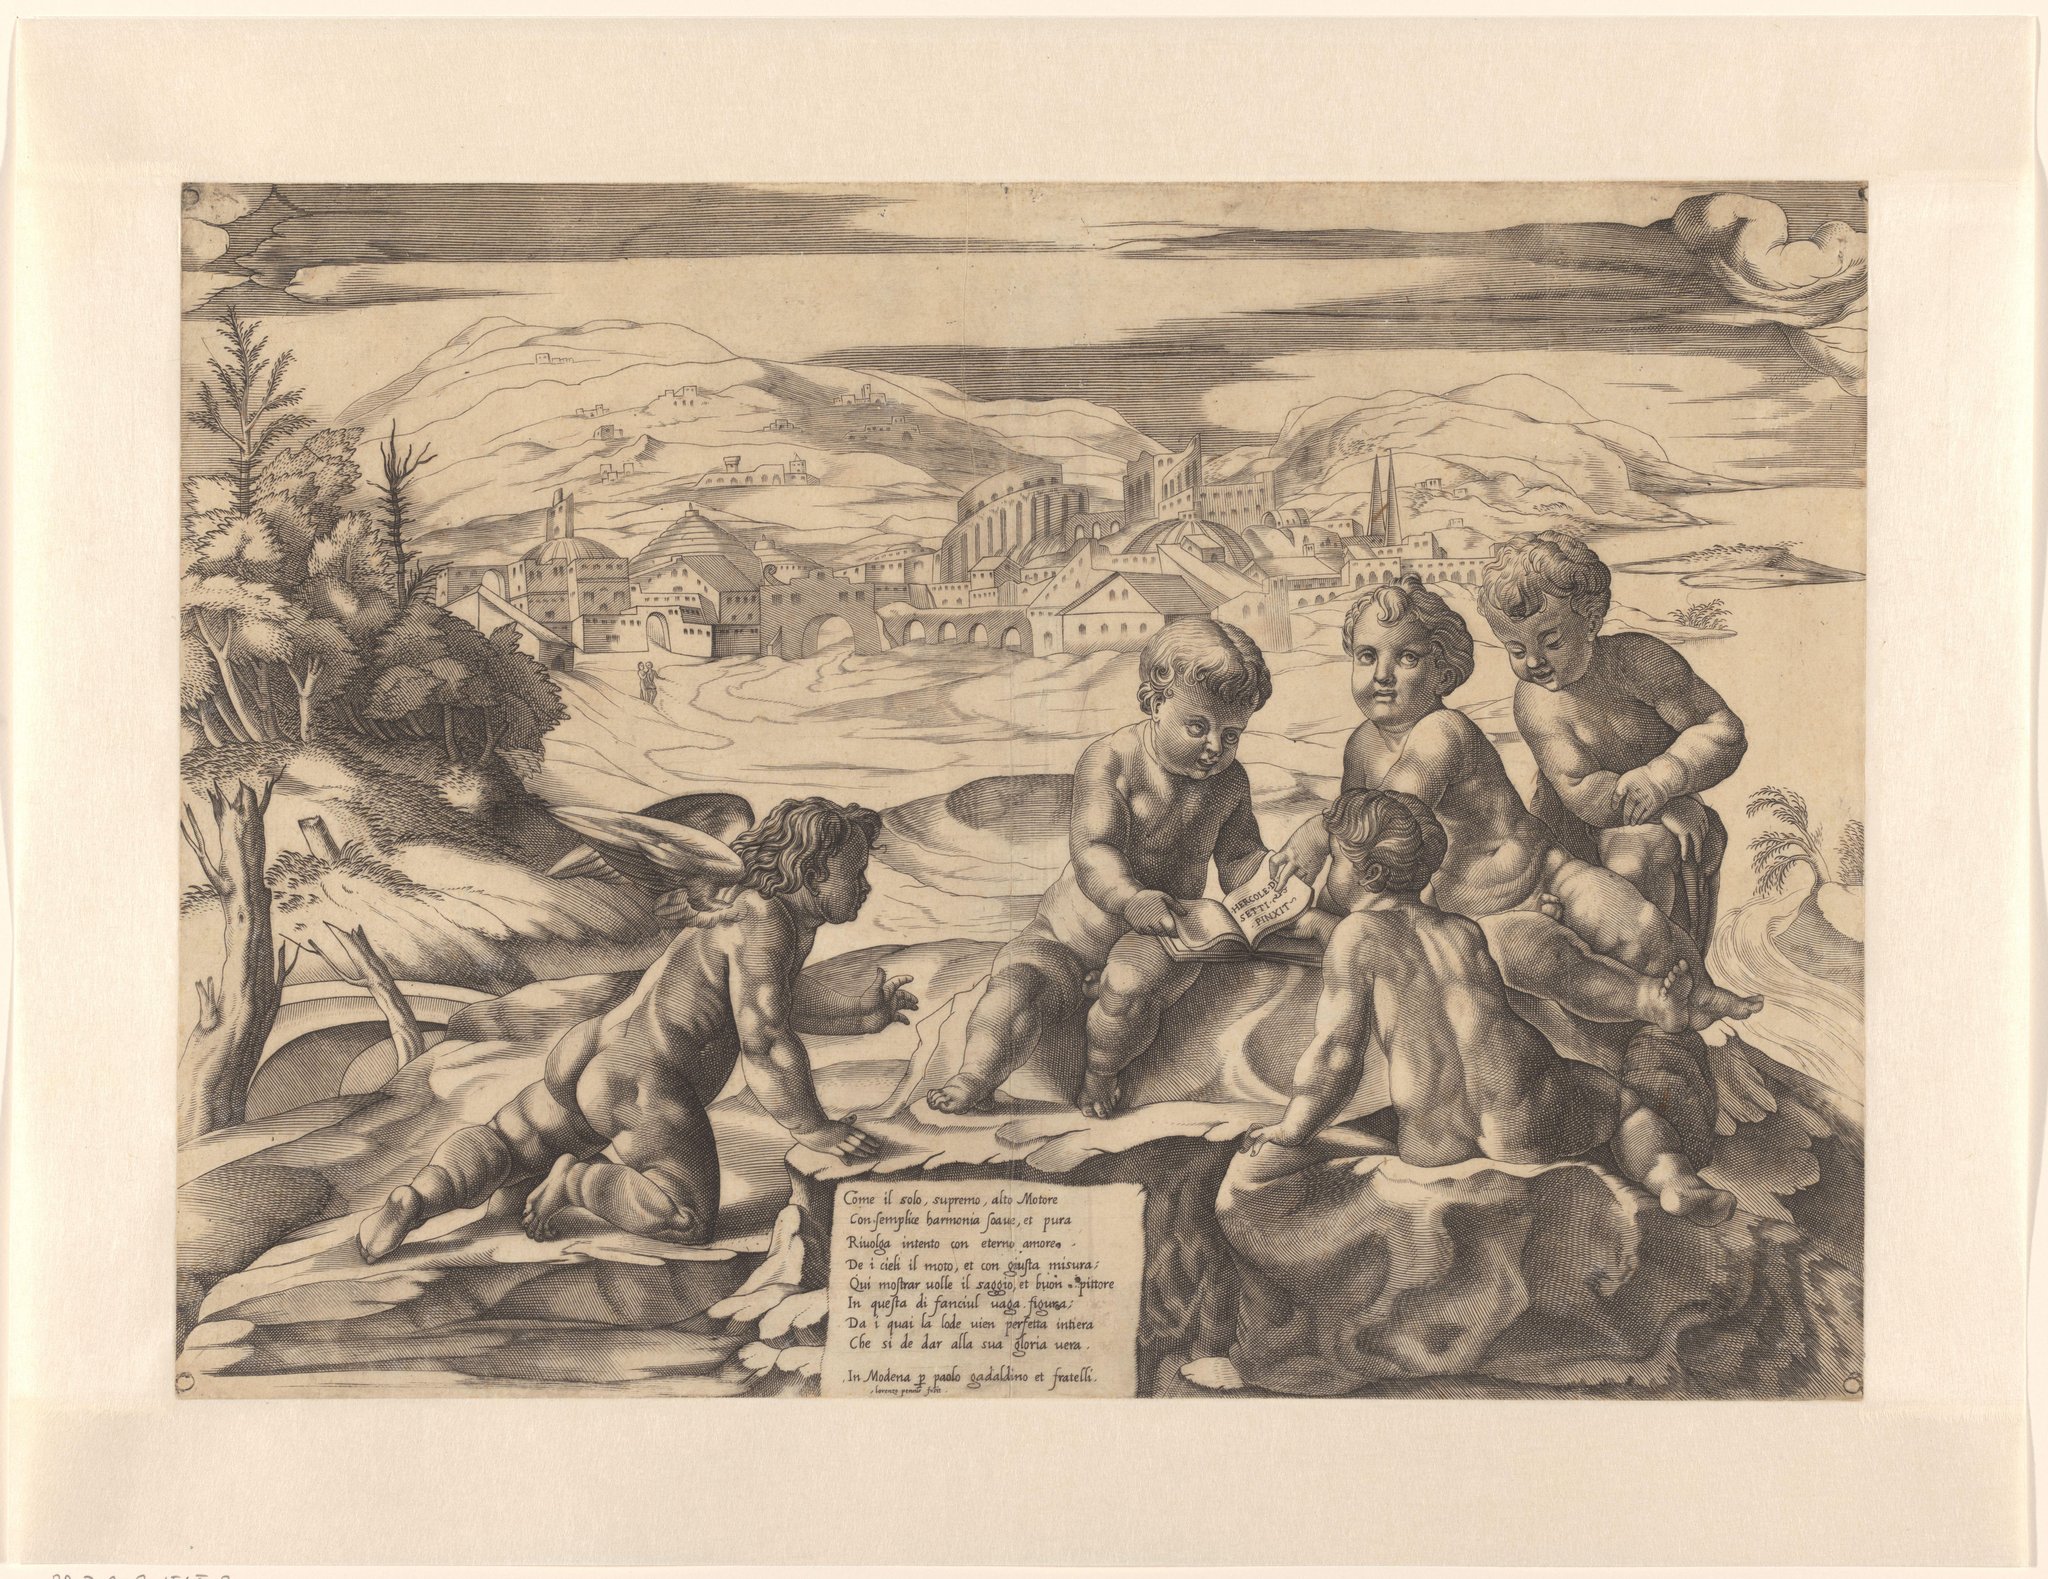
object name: print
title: Vier jongetjes en een putto in een landschap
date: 1560-1580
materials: paper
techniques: engraving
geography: italy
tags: children's games and plays, child, cupids: 'amores', 'amoretti', 'putti'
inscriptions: collector's mark: Lugt 2760, collector's mark: Lugt 2228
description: Vier jongetjes met een boek en een putto in een landschap. Centraal onderaan een cartouche met achtregelig vers in het Italiaans.